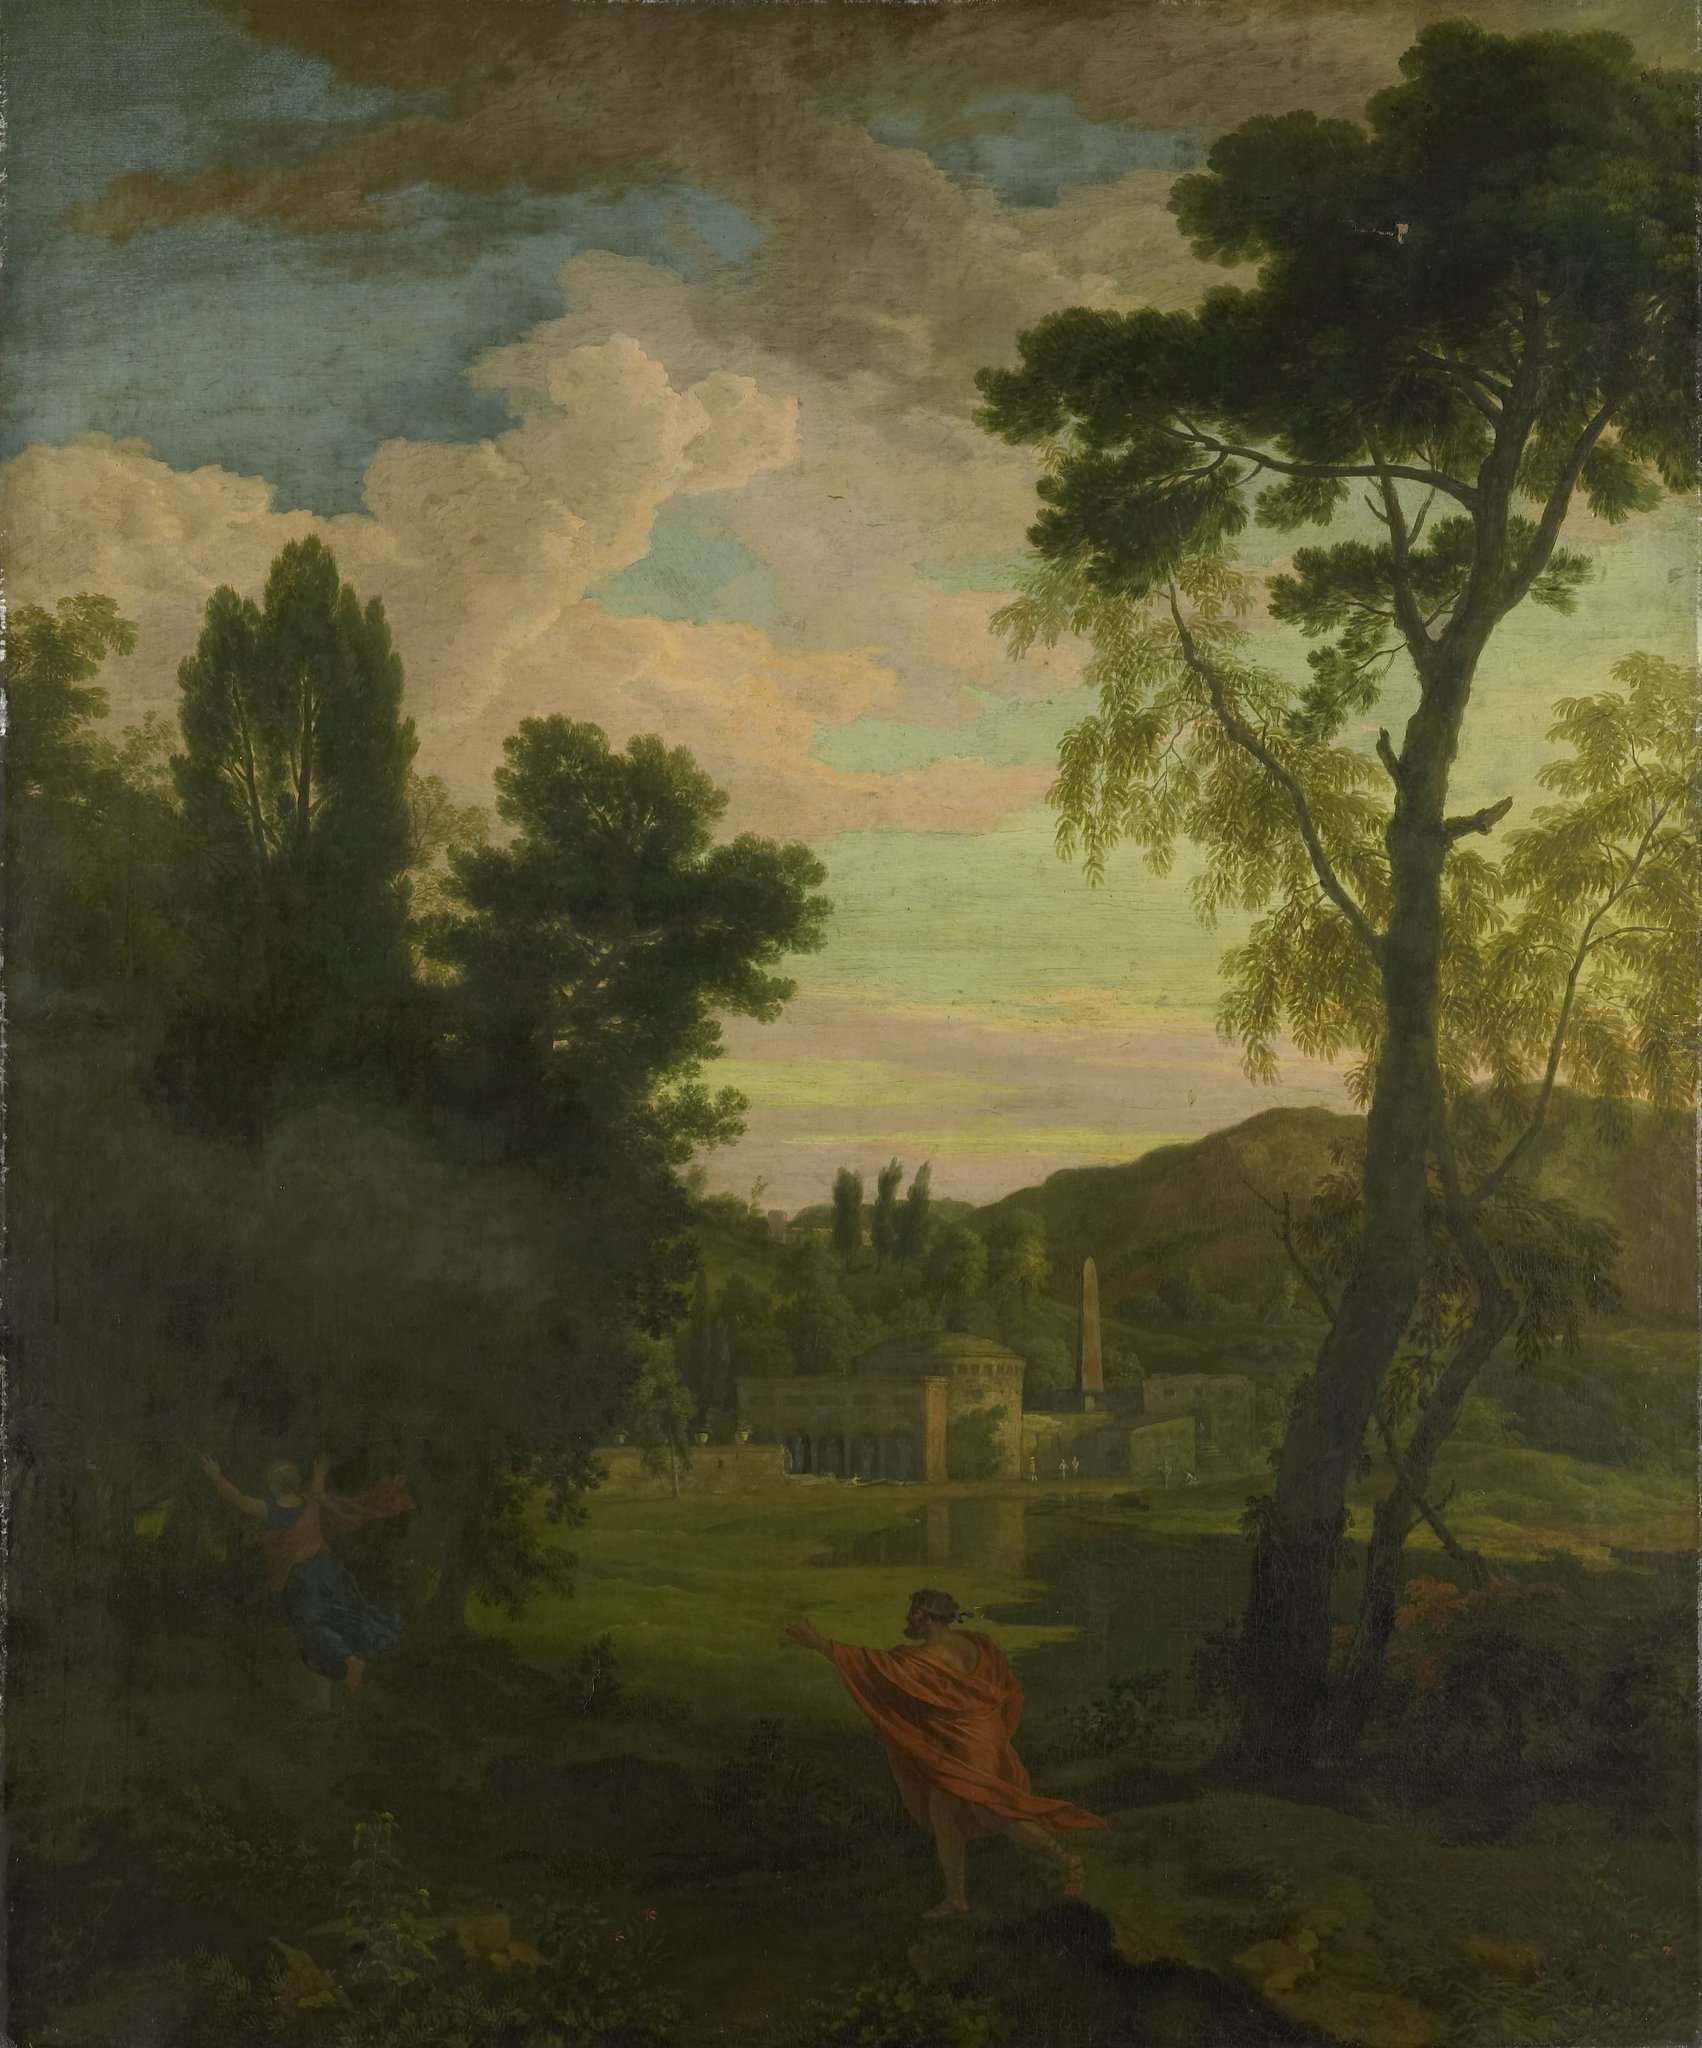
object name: mural painting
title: Arcadian Landscape with Jupiter and Io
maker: johannes glauber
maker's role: draughtsman, painter, print maker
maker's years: 1646-1726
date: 1680-1726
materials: canvas, oil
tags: io changed into a cow: to avoid detection by juno, jupiter changes io into a cow (ovid, metamorphoses i 611), pastorals, arcadian scenes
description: Arcadisch landschap met Jupiter en Io. Op de achtergrond een tempel en een obelisk bij een riviertje. Rechts een alleenstaande hoge boom.